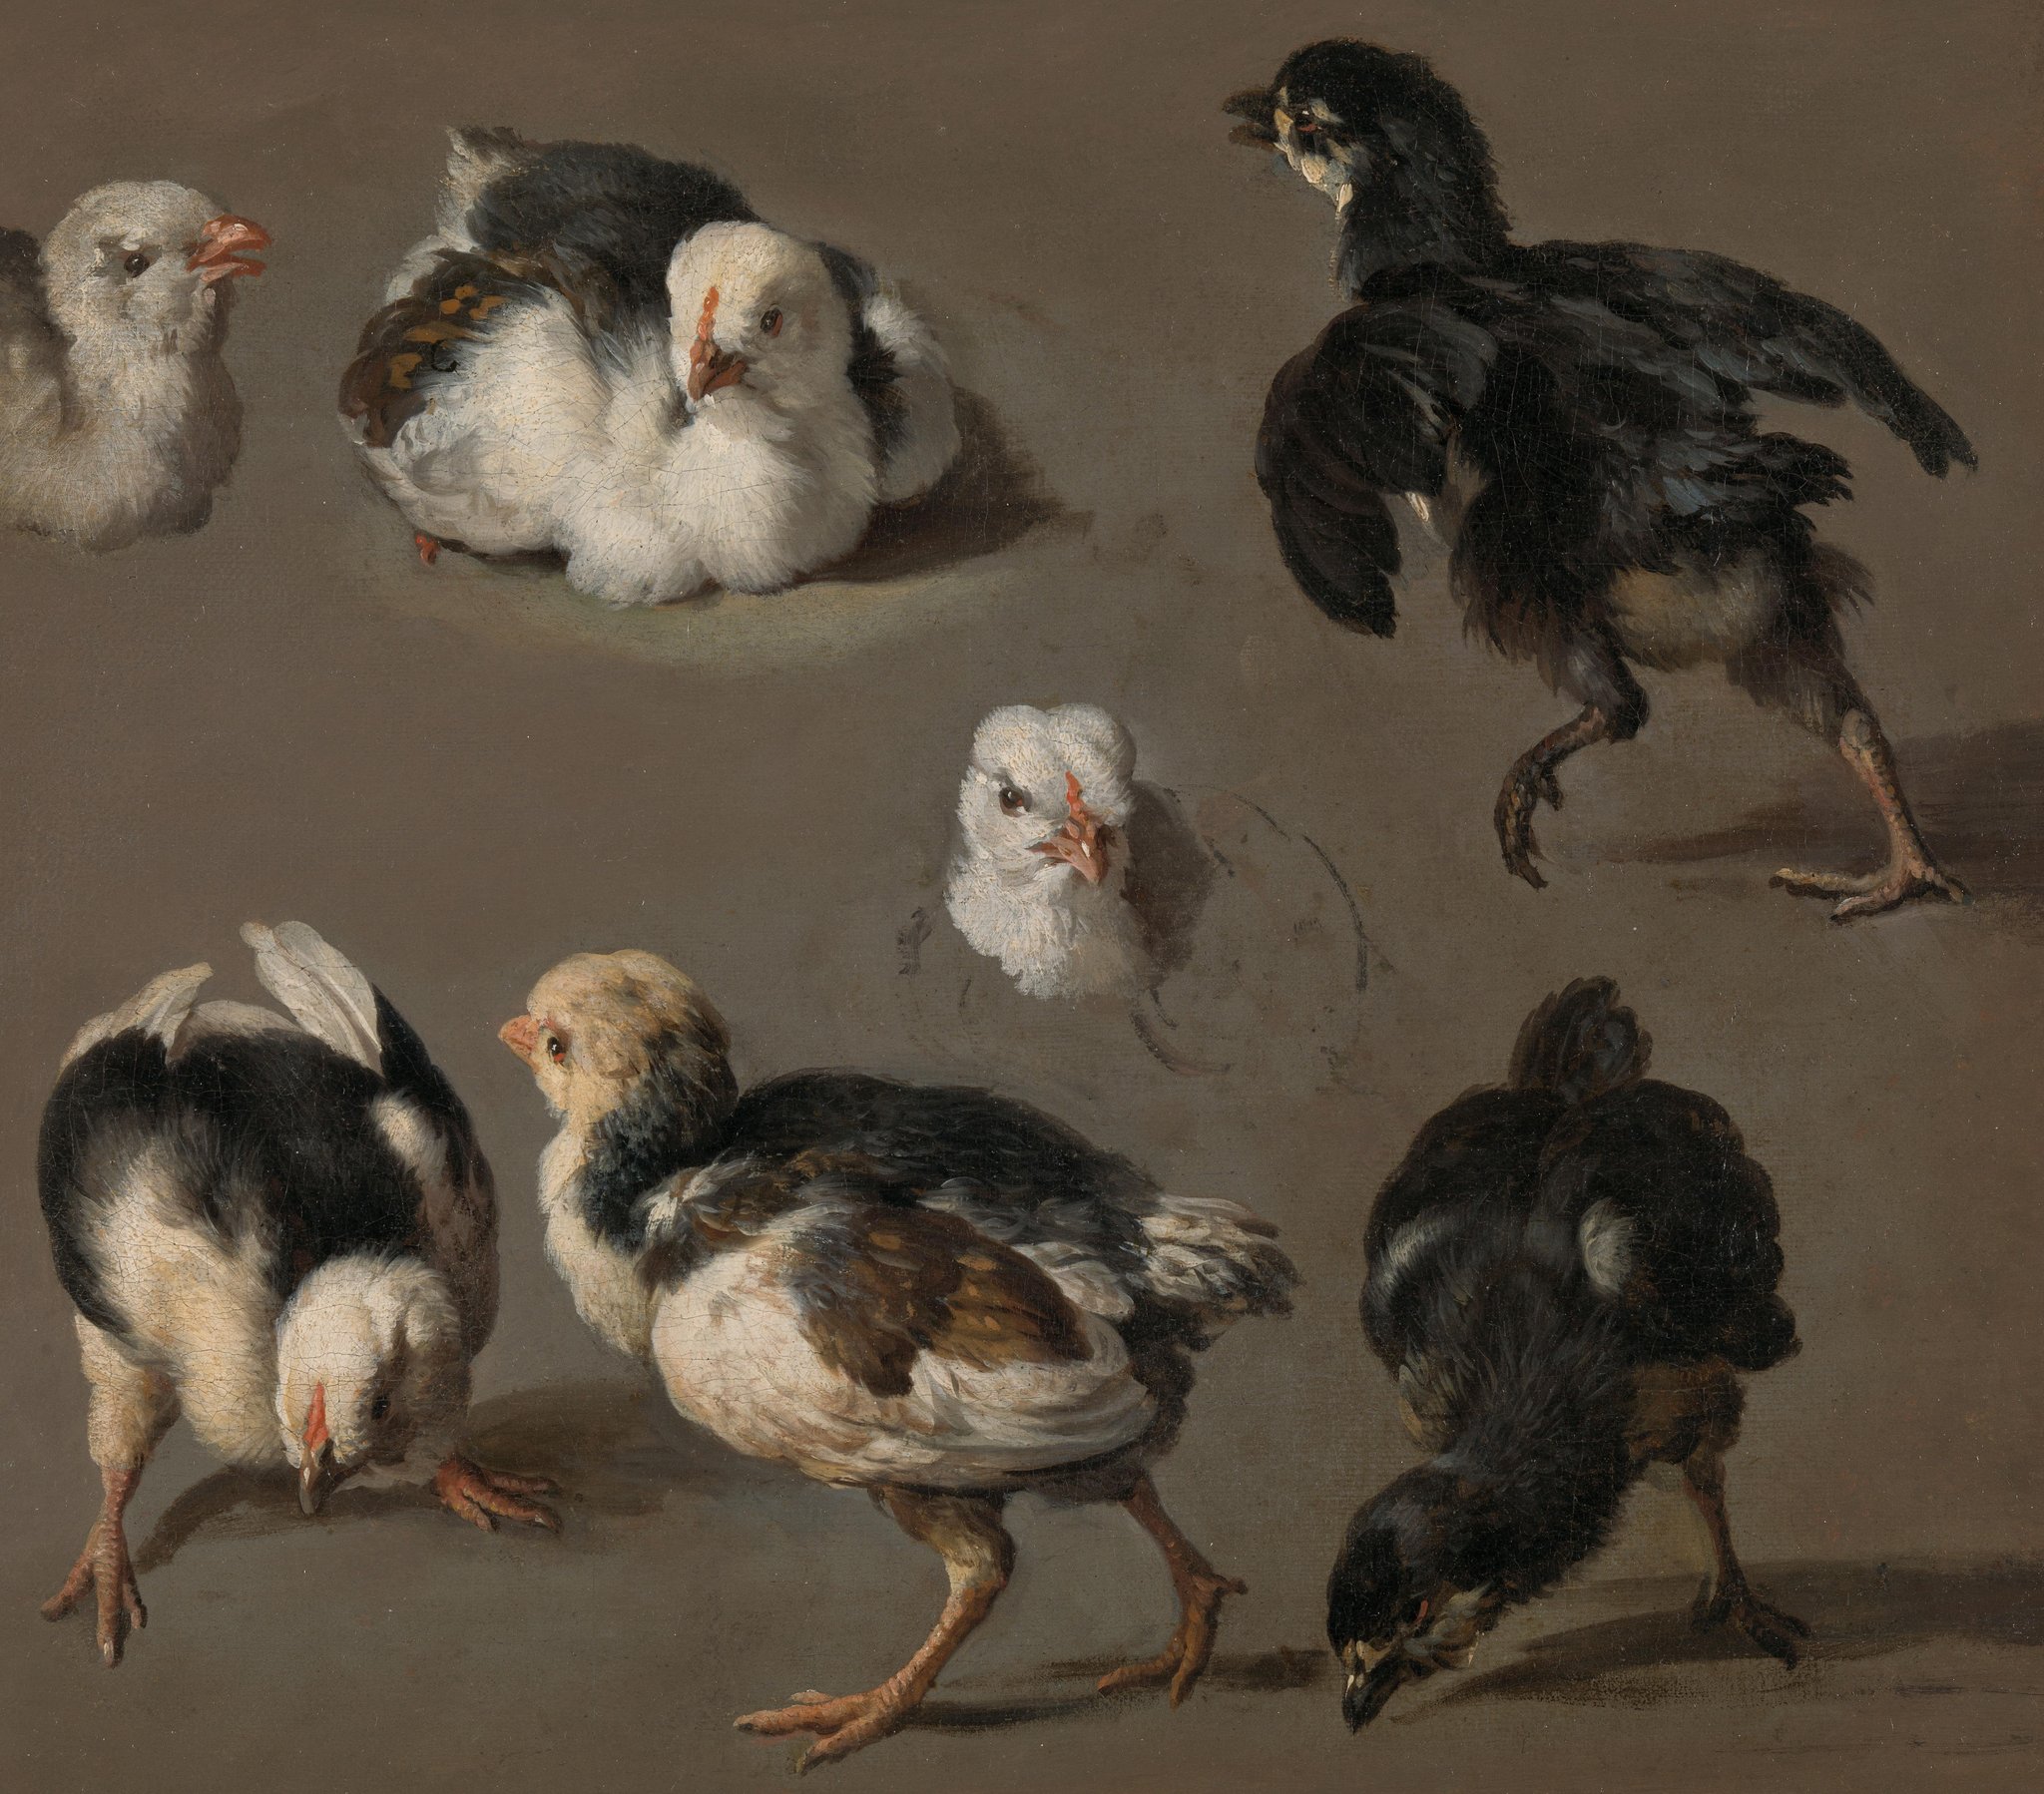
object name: painting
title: Seven Chicks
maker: melchior d hondecoeter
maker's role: draughtsman, painter, print maker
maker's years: 1636-1695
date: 1665-1668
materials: canvas, oil, paint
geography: northern netherlands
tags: fowl (cock, hen, chicken, etc.)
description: This oil sketch of chicks affords unique insight into the working method of Melchior d'Hondecoeter, the best-known bird painter of the 17th century. He used such studies as the basis for his monumental park landscapes, which feature diverse species of birds. Depicted in this sketch are seven chicks in various poses. They were frequently reused in a ‘copy & paste’ fashion in his paintings.